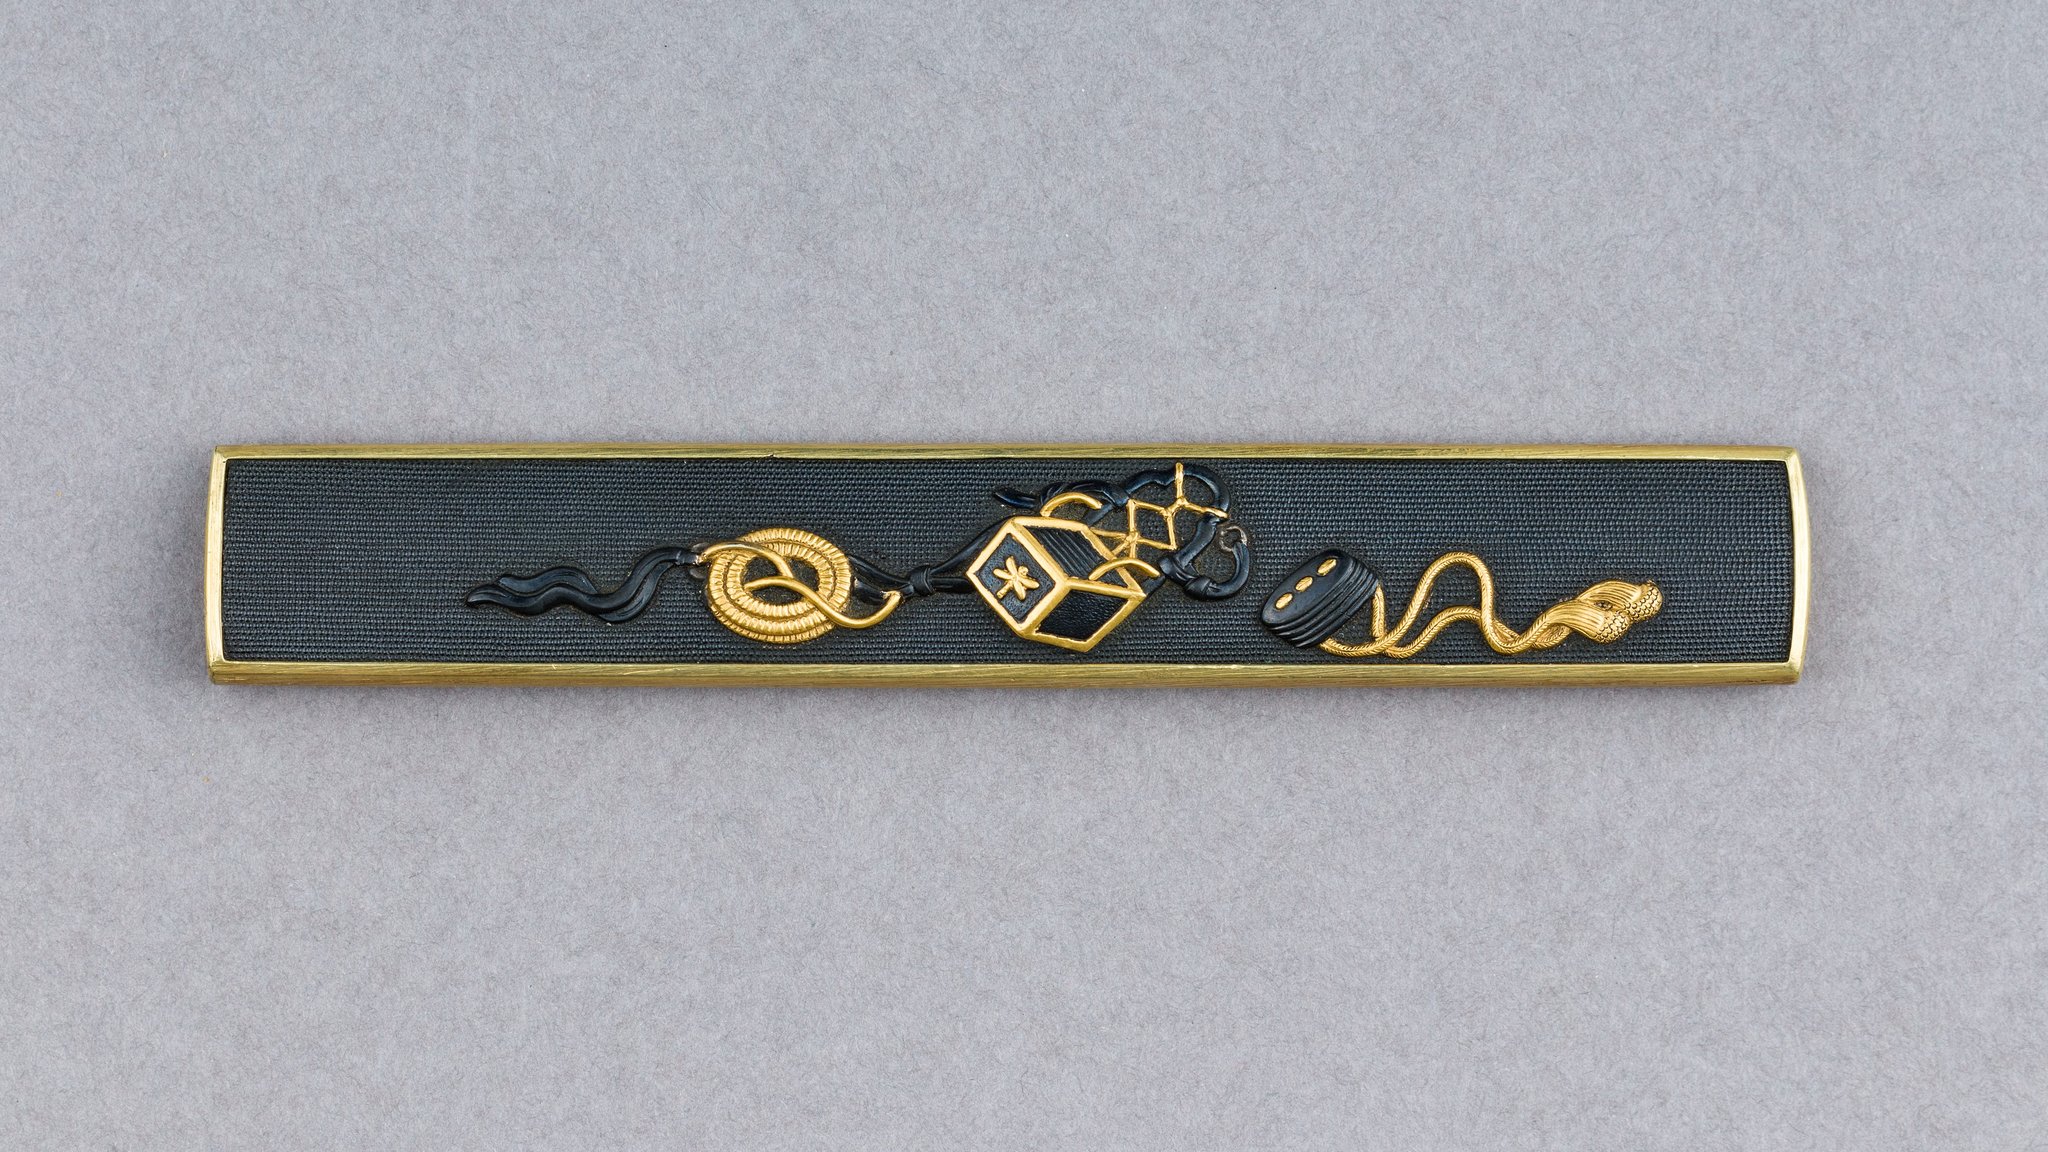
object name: knife handle kozuka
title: Knife Handle (Kozuka)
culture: japanese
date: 1615-1868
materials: gold alloy, gold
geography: japan